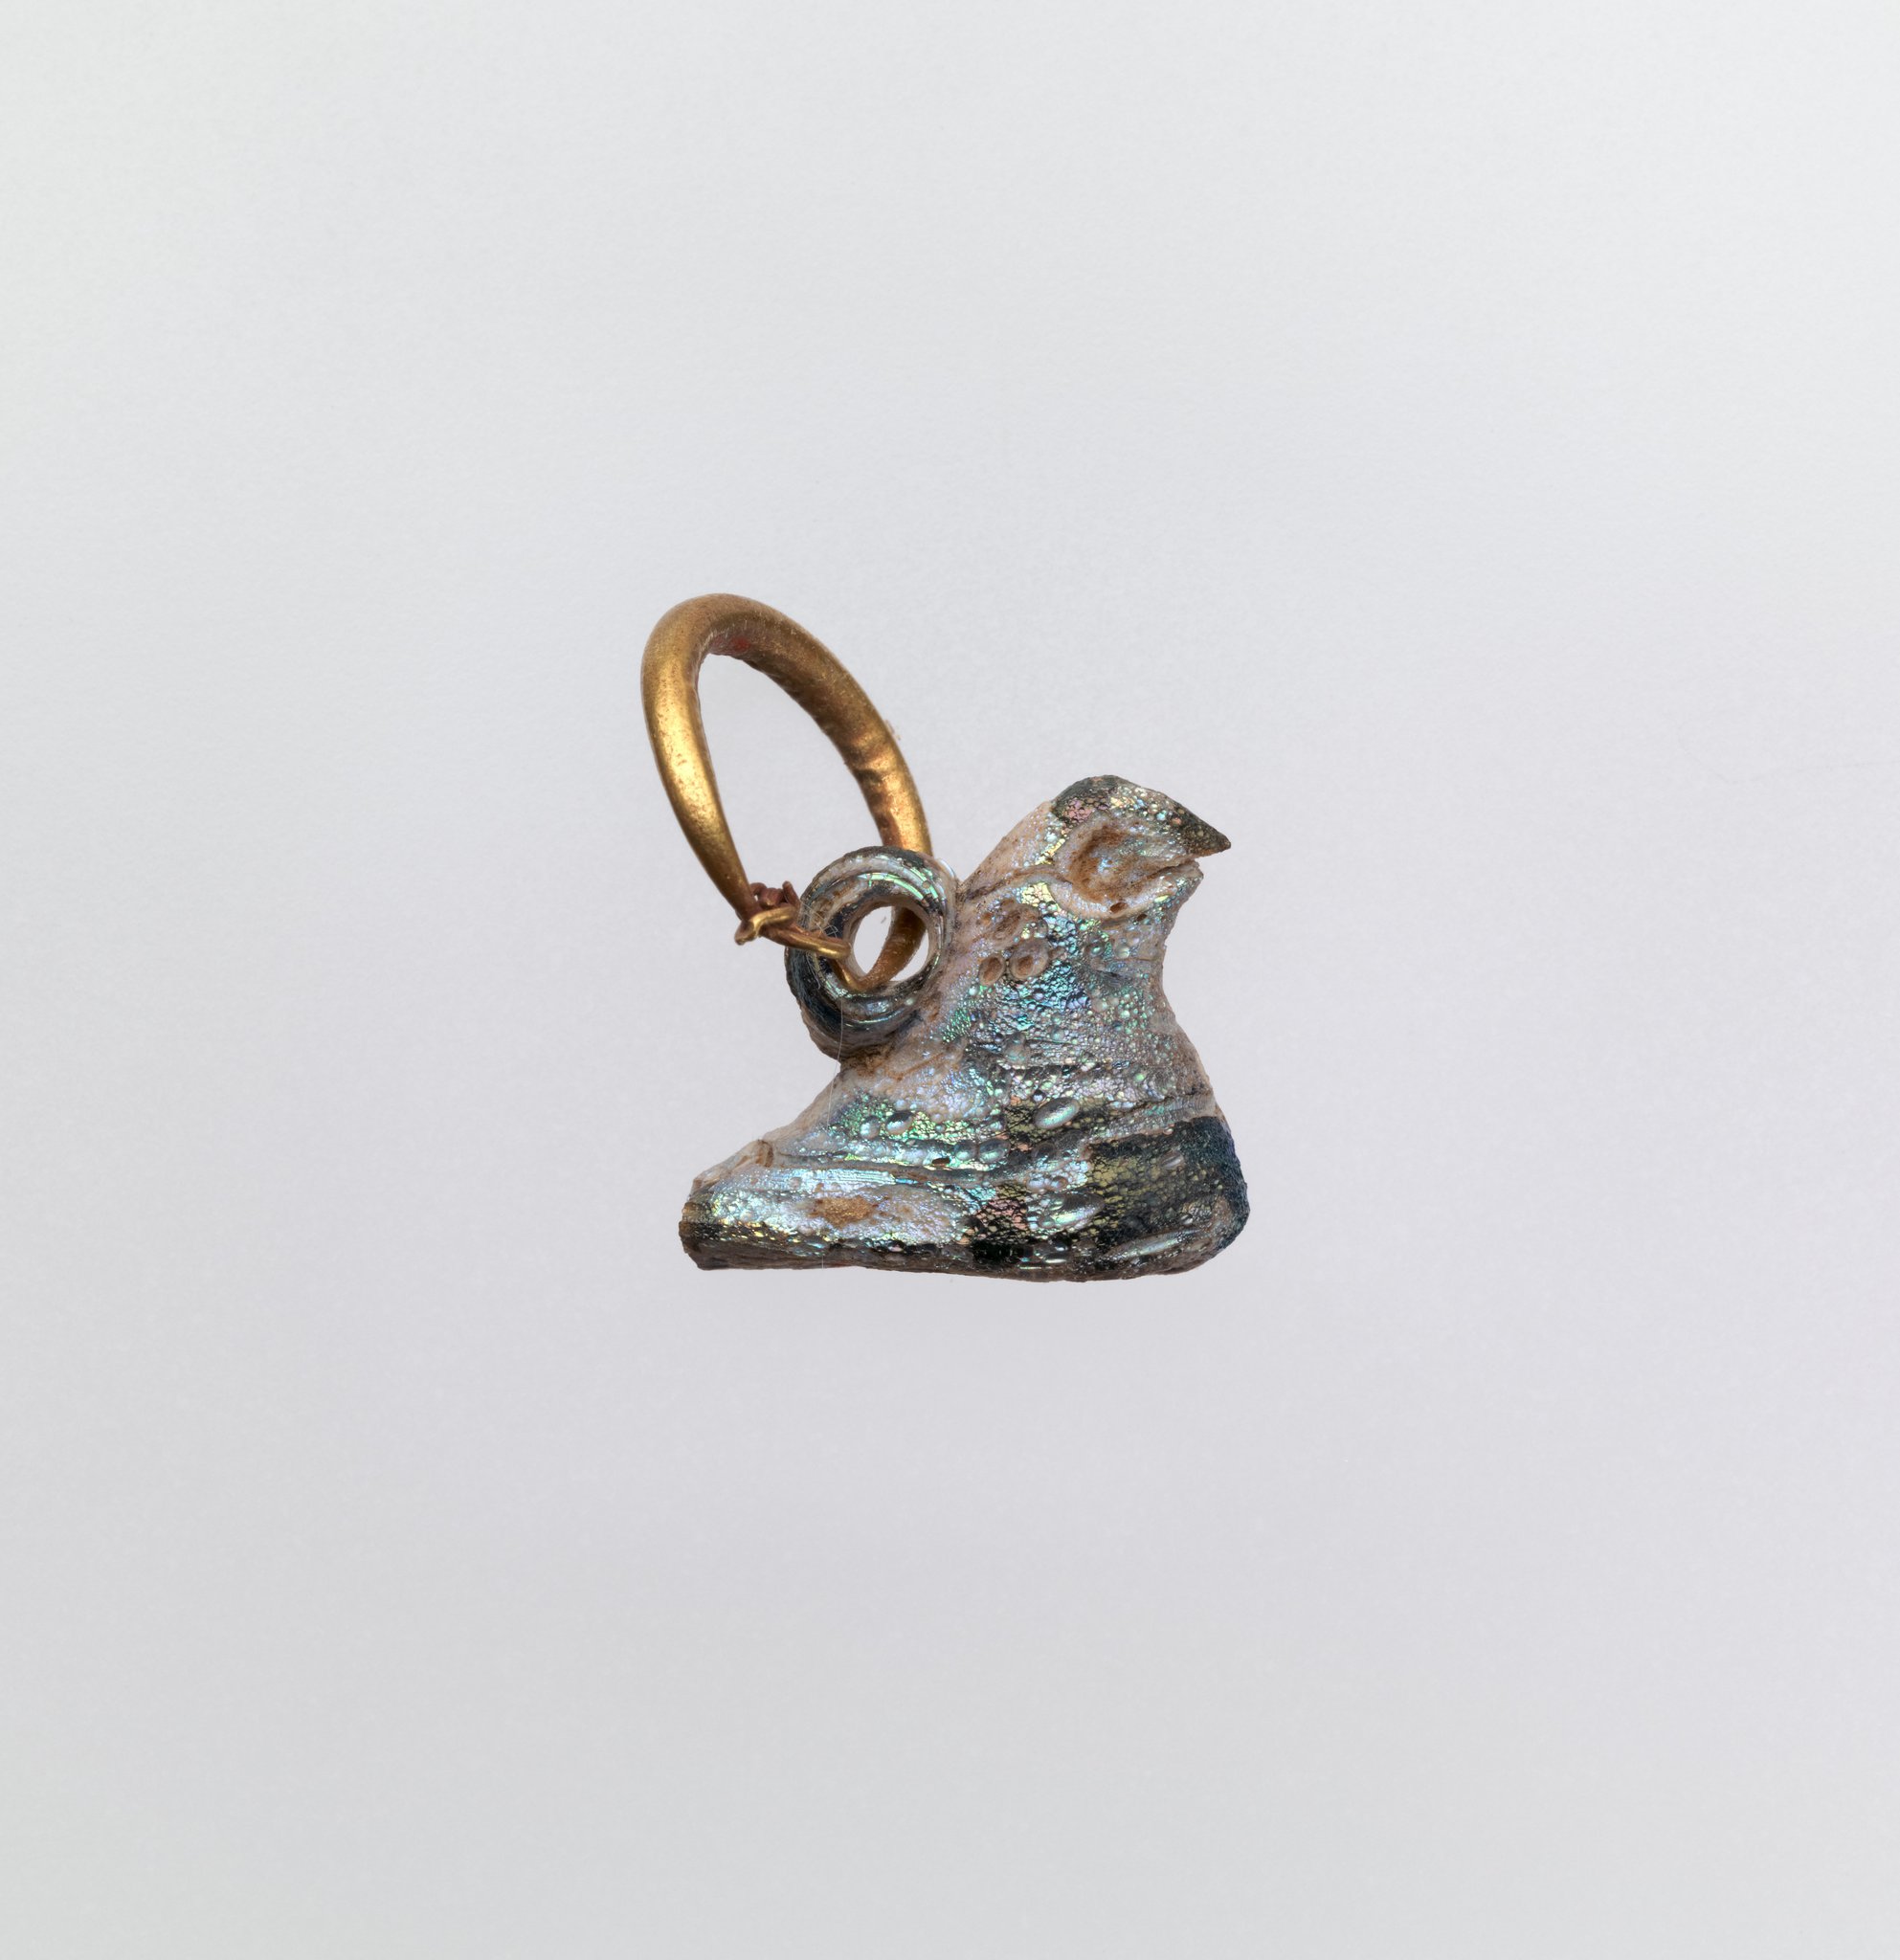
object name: earring with pendant of bird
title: Gold earring with glass pendant in the form of a bird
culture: phoenician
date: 434-201 BCE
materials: glass, gold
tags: birds